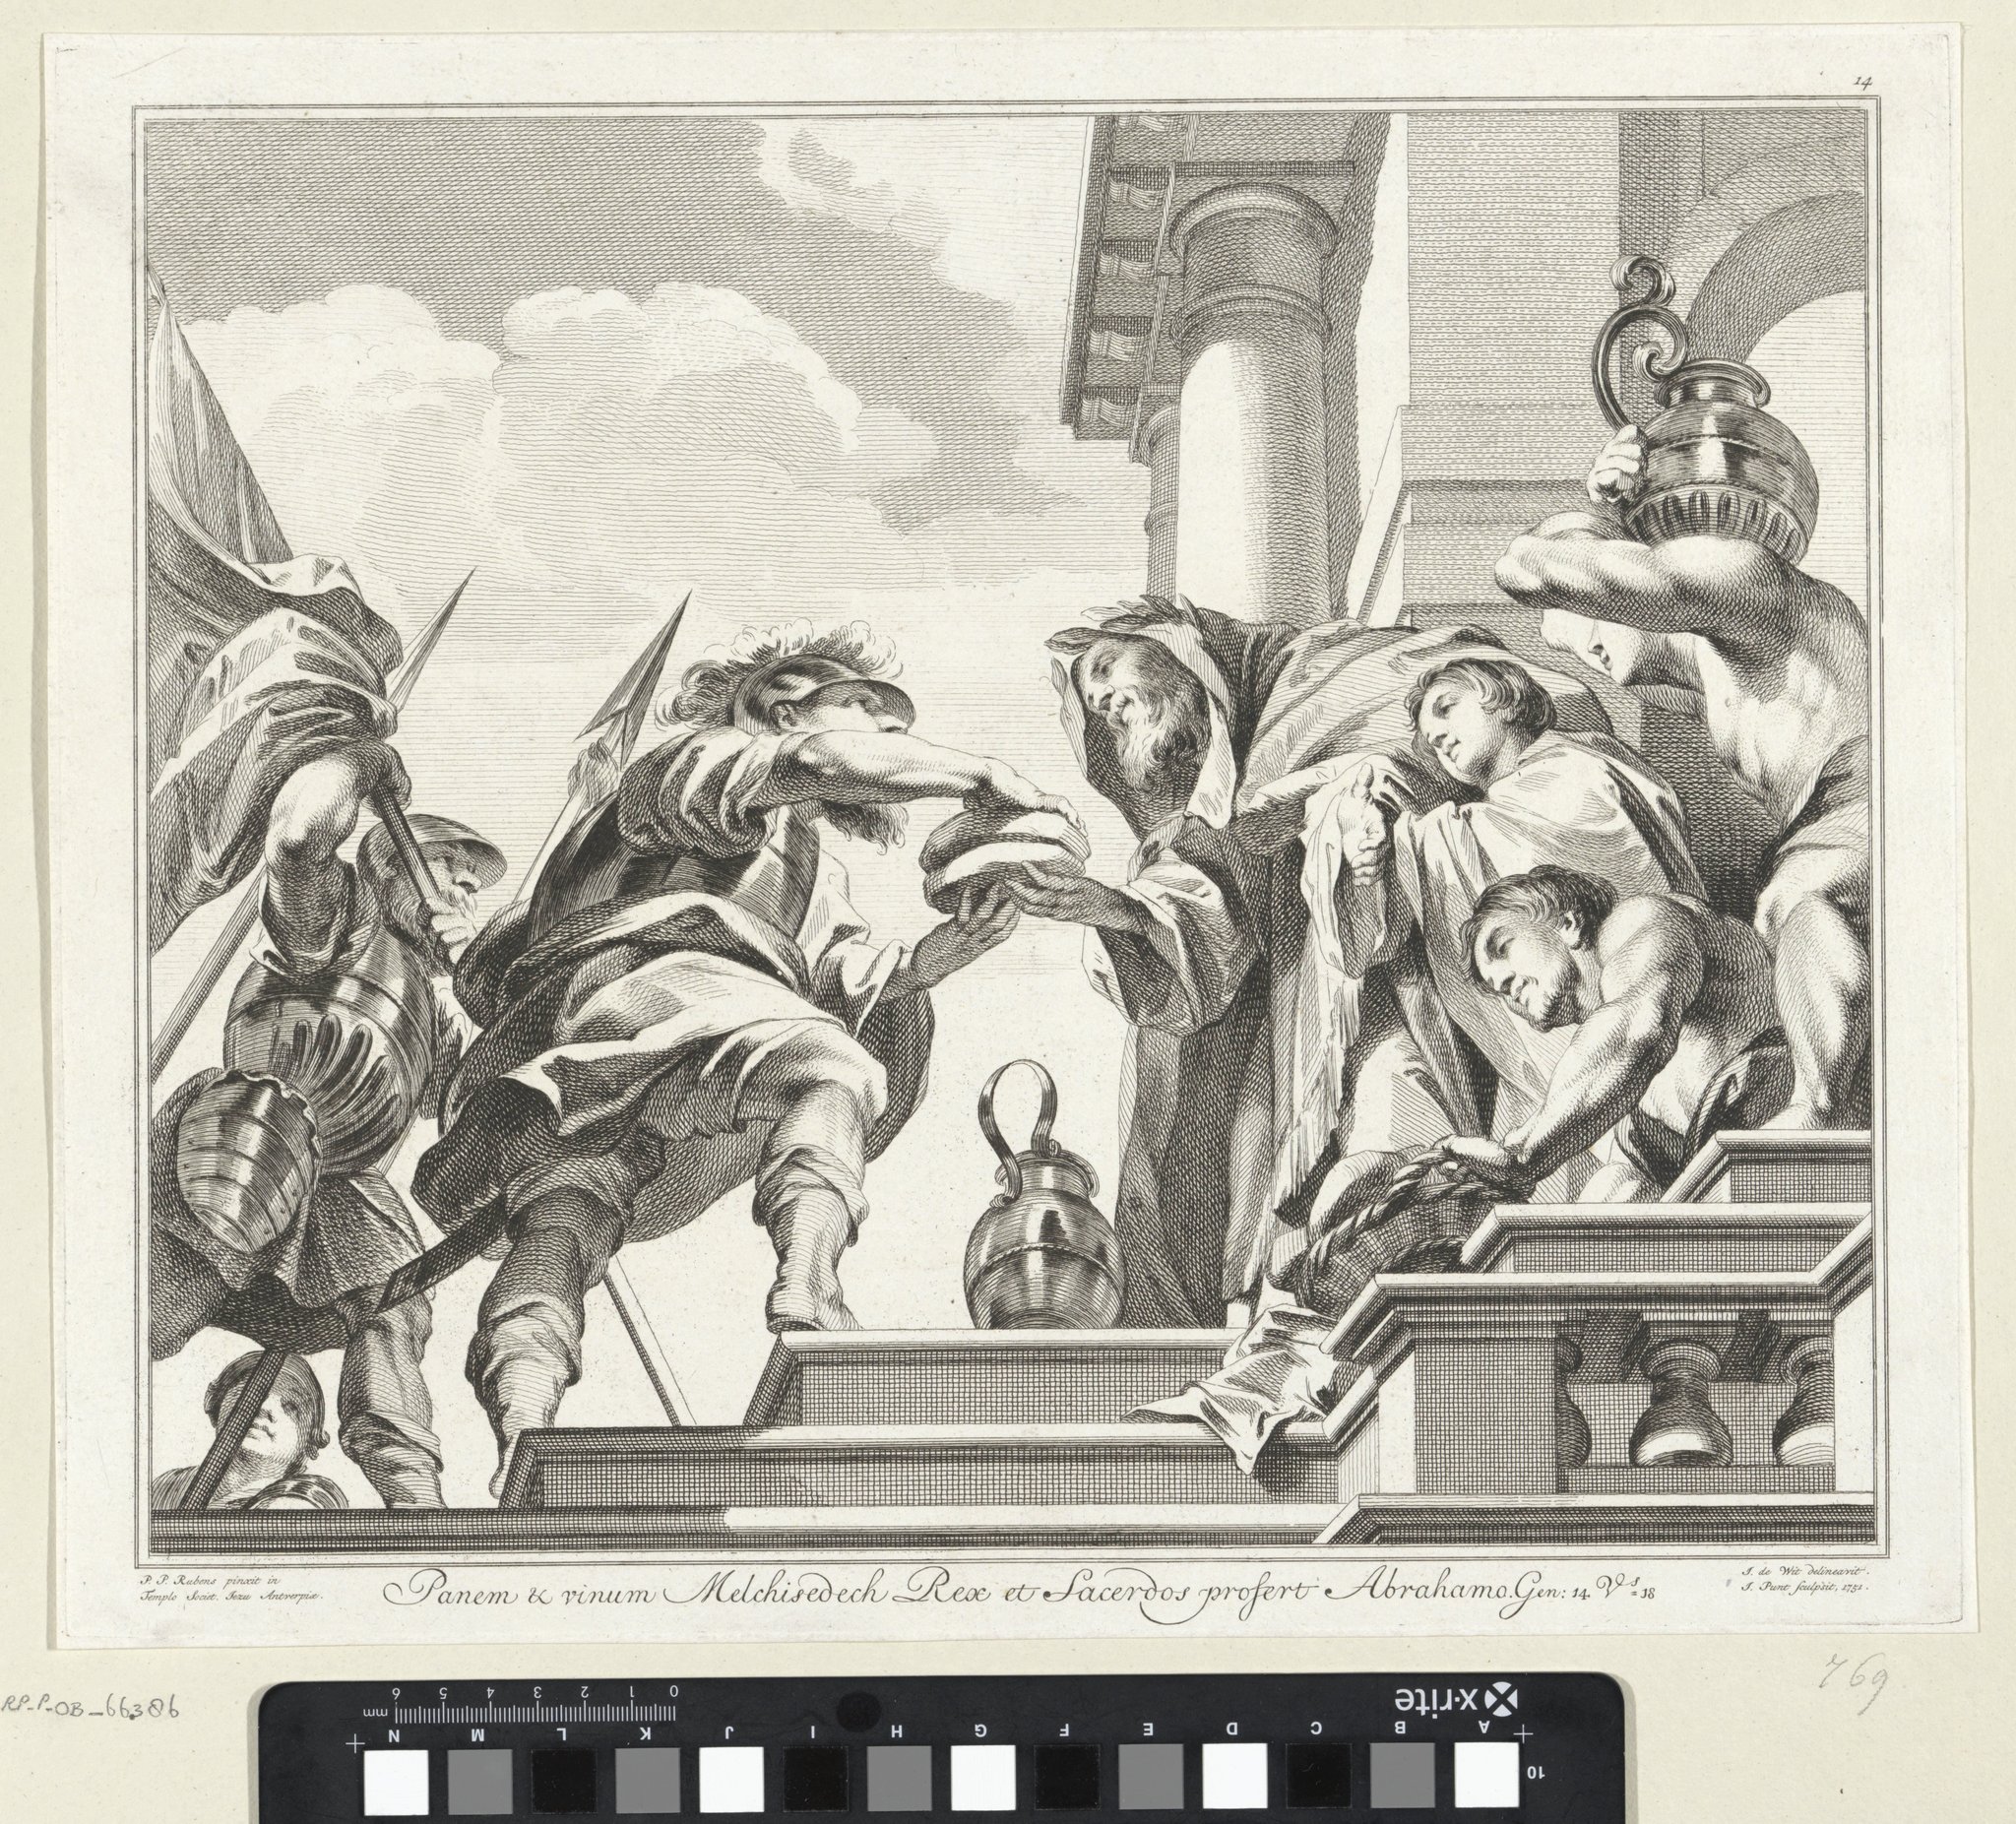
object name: print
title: Melchisedek biedt Abraham brood en wijn aan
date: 1751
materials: paper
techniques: engraving, etching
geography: amsterdam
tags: the meeting of abraham and melchizedek, the high priest and king of salem, who brings bread and wine (genesis 14:18-20)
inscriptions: date: ‘1751’, collector's mark: Lugt 240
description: Melchisedek staat op een trap en overhandigt twee broden aan Abraham. Onder de rechthoekige voorstelling een vers in het Latijn uit Gen. 14:18.